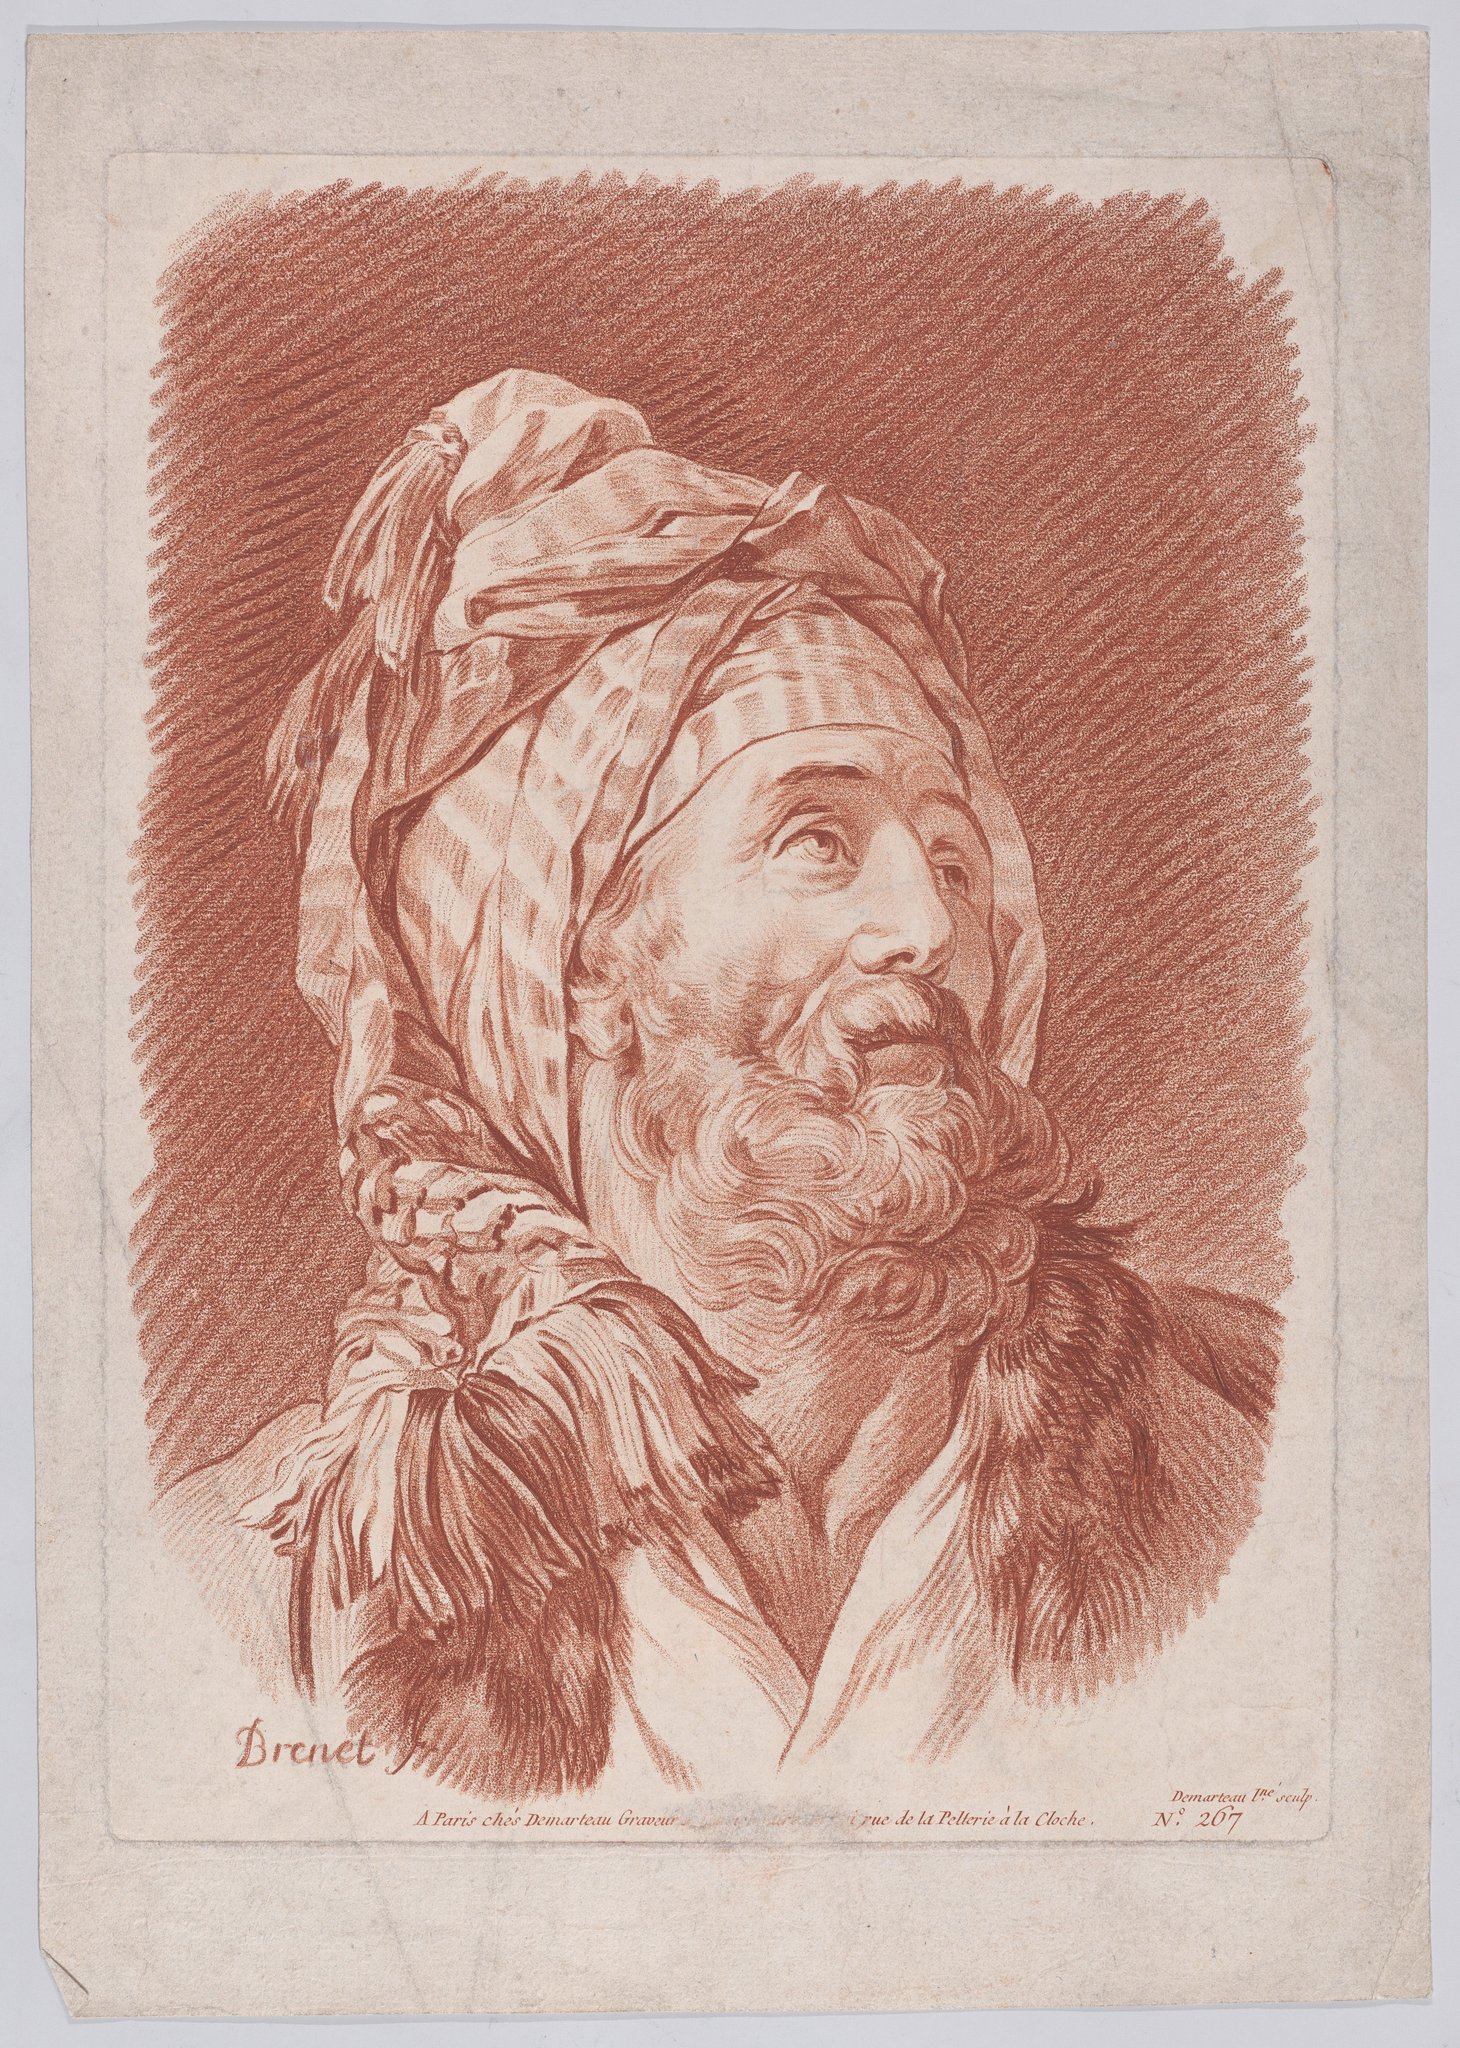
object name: print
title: Head of a Turk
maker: gilles demarteau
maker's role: artist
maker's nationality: french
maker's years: 1722-1776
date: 1746-1776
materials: ink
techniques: printmaking, etching, printing